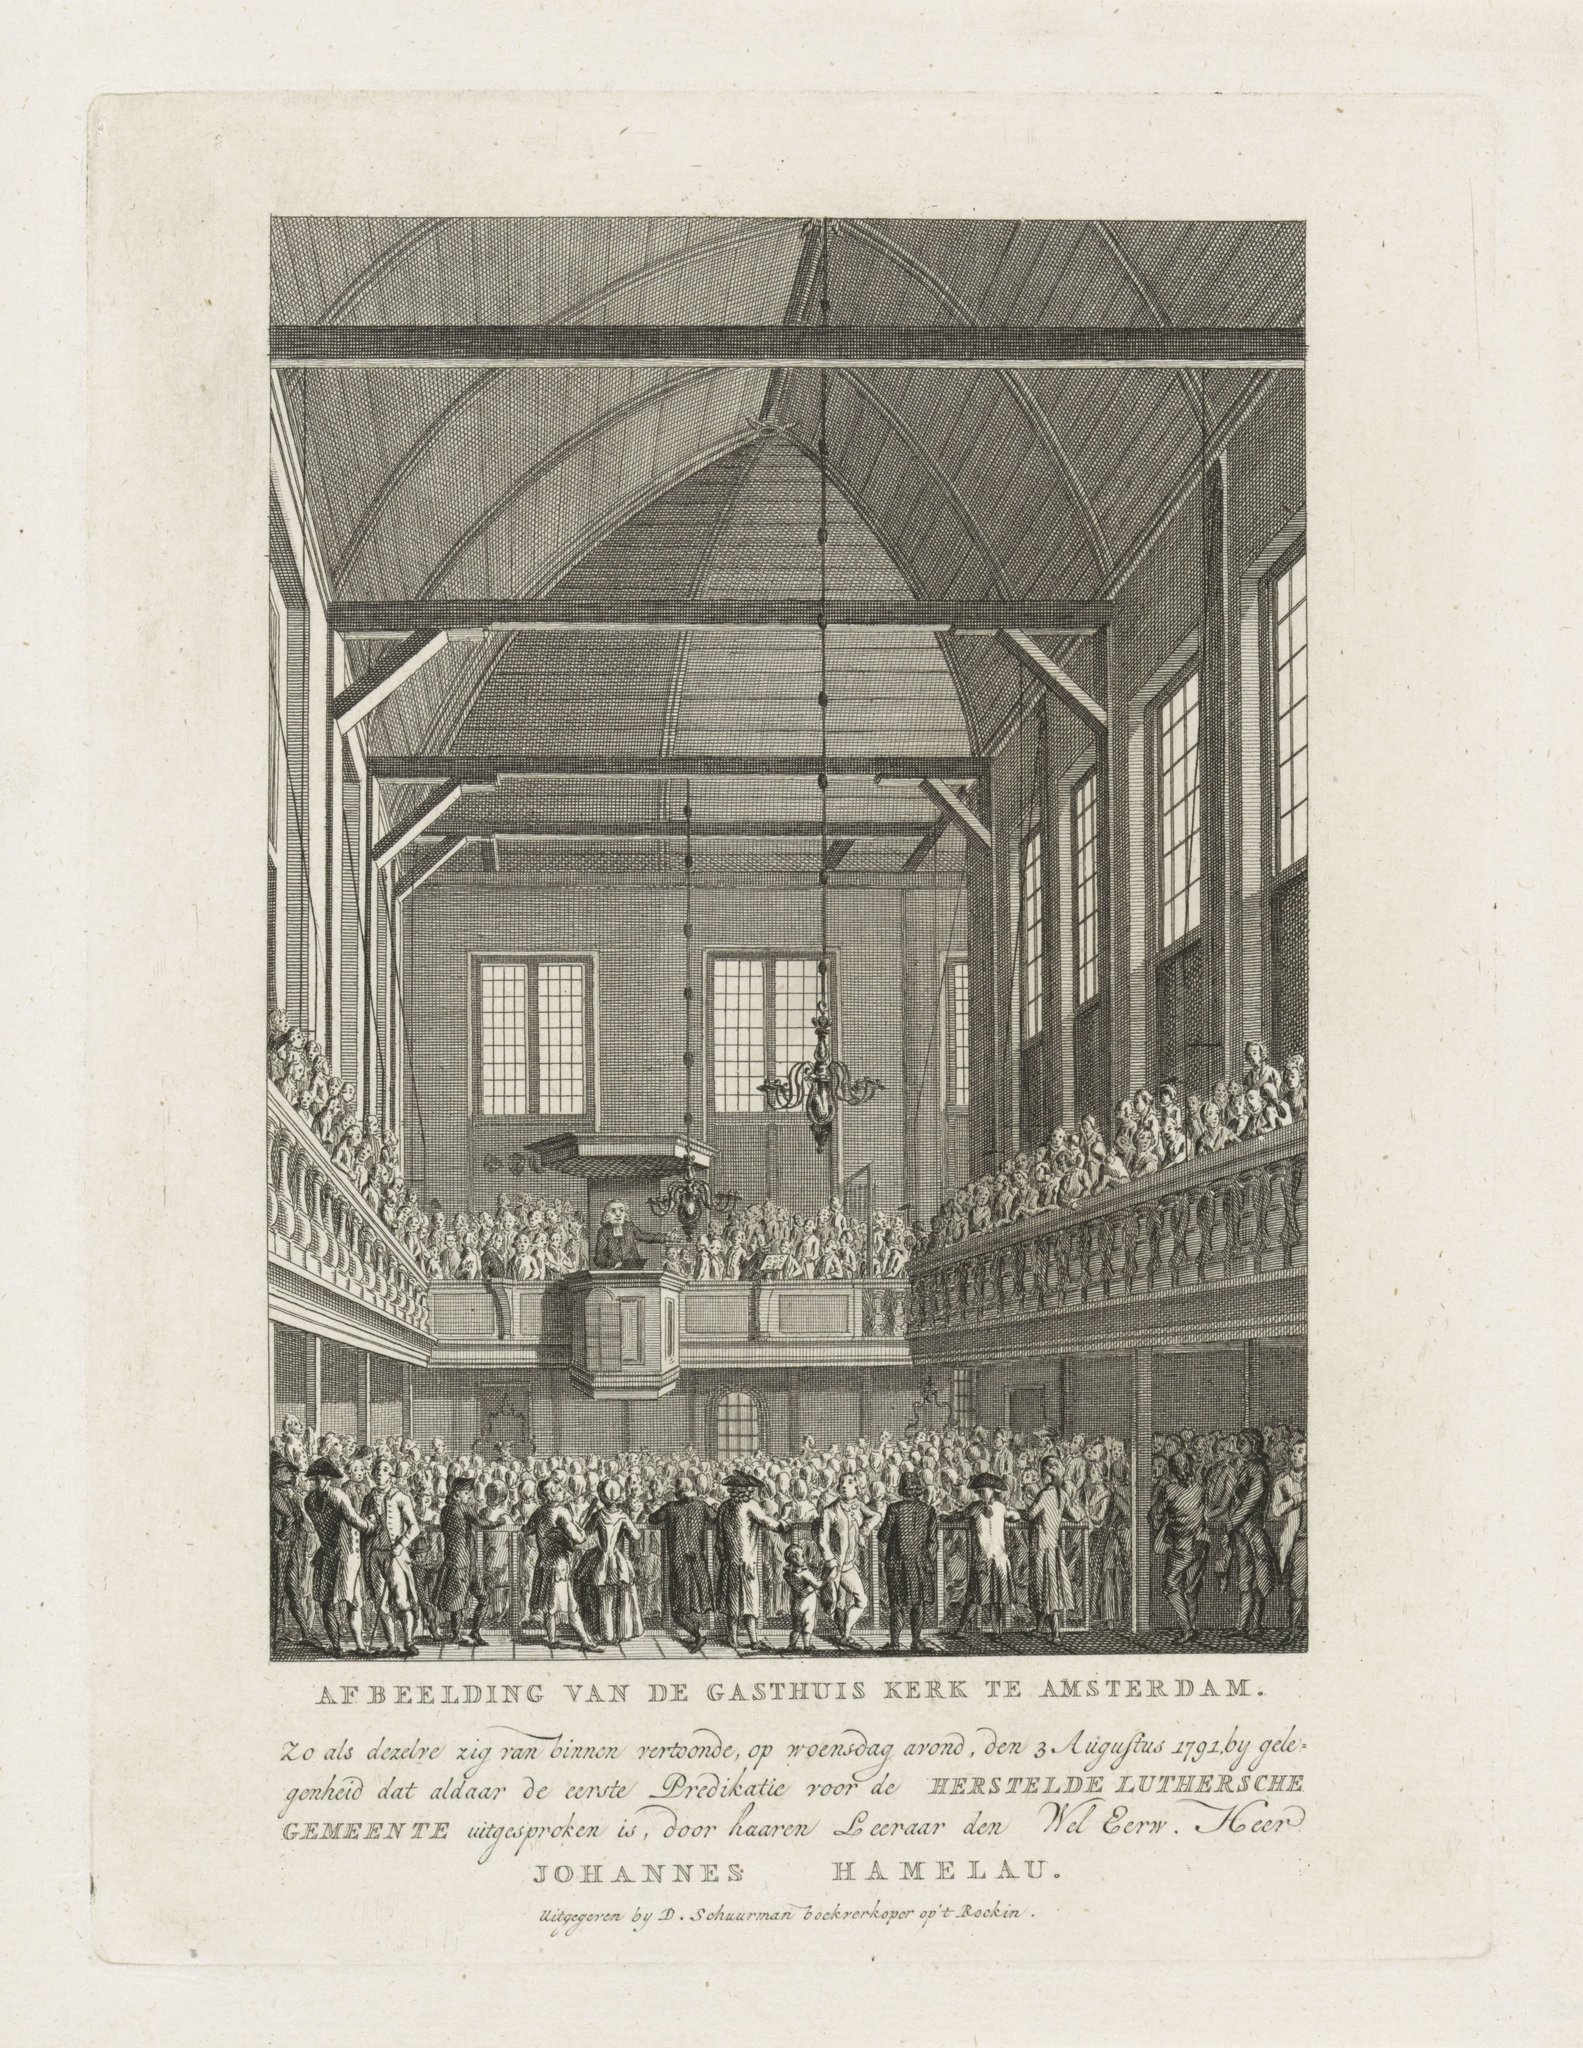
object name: print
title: Afbeelding van de Gasthuis Kerk te Amsterdam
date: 1791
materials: paper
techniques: etching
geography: northern netherlands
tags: sermon ~ protestant service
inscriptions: collector's mark: Lugt 2228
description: Eerste prediking voor de Herstelde Lutherse Gemeente (Evangelisch Lutherse Gemeente) door de predikant Johannes Hamelau in de Gasthuiskerk te Amsterdam, 3 augustus 1791. Volle kerkinterieur met de predikant in de preekstoel.